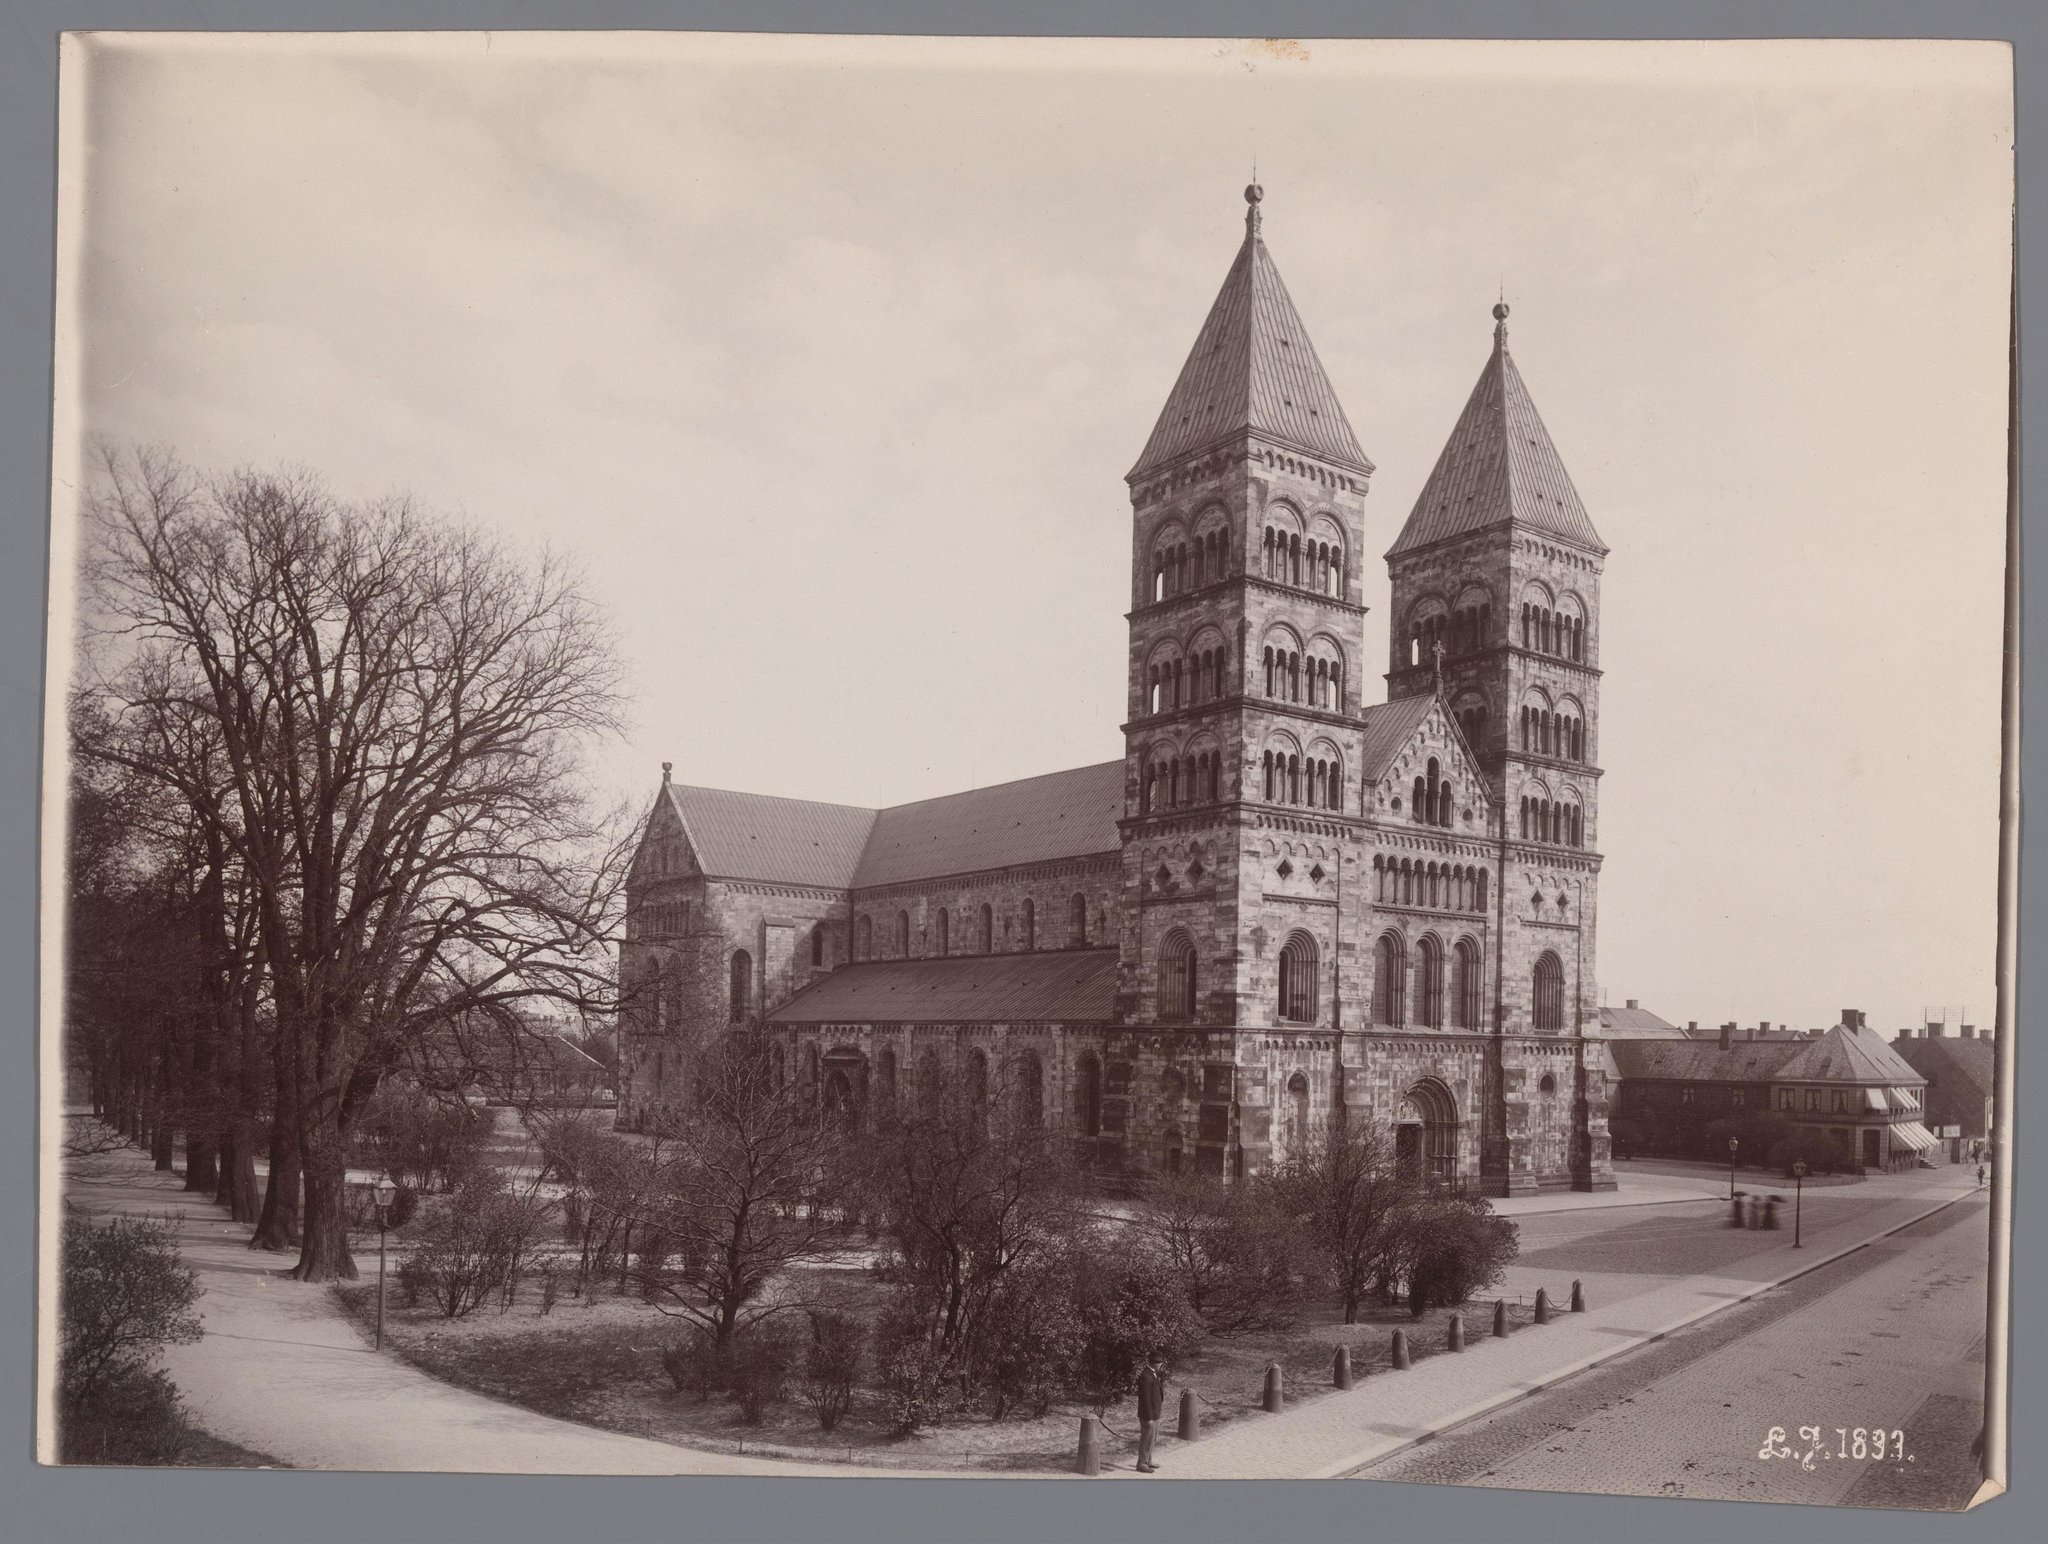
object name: photograph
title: Gezicht op de Dom van Lund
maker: Anonymous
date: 1915-1960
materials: paper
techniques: gelatin silver print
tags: protestant churches and denominations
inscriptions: number: ‘L. J. 1893.’